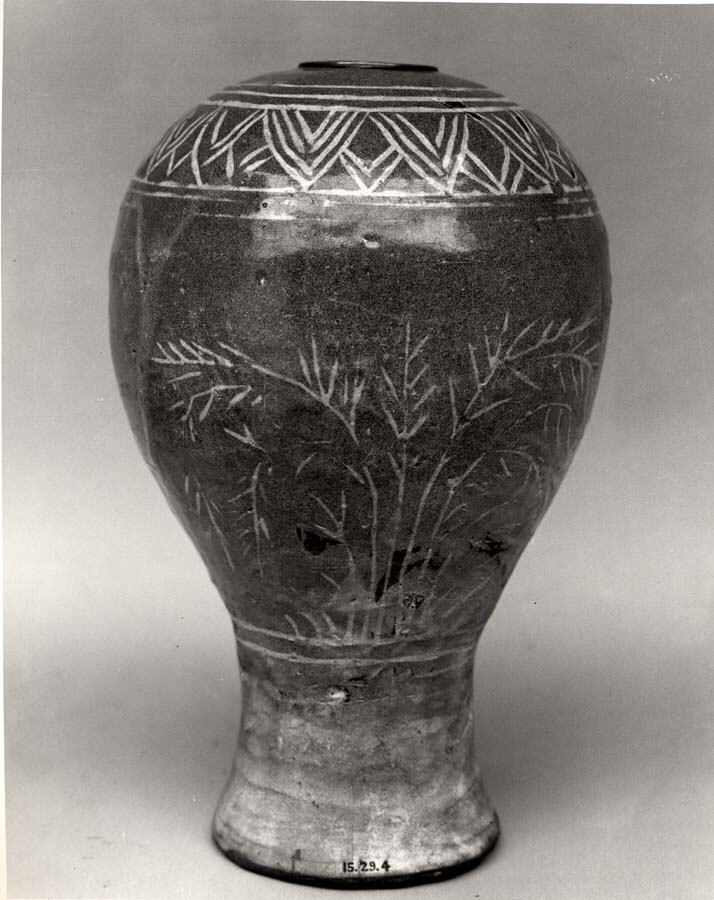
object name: vase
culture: korean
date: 1901-1933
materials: pottery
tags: plants